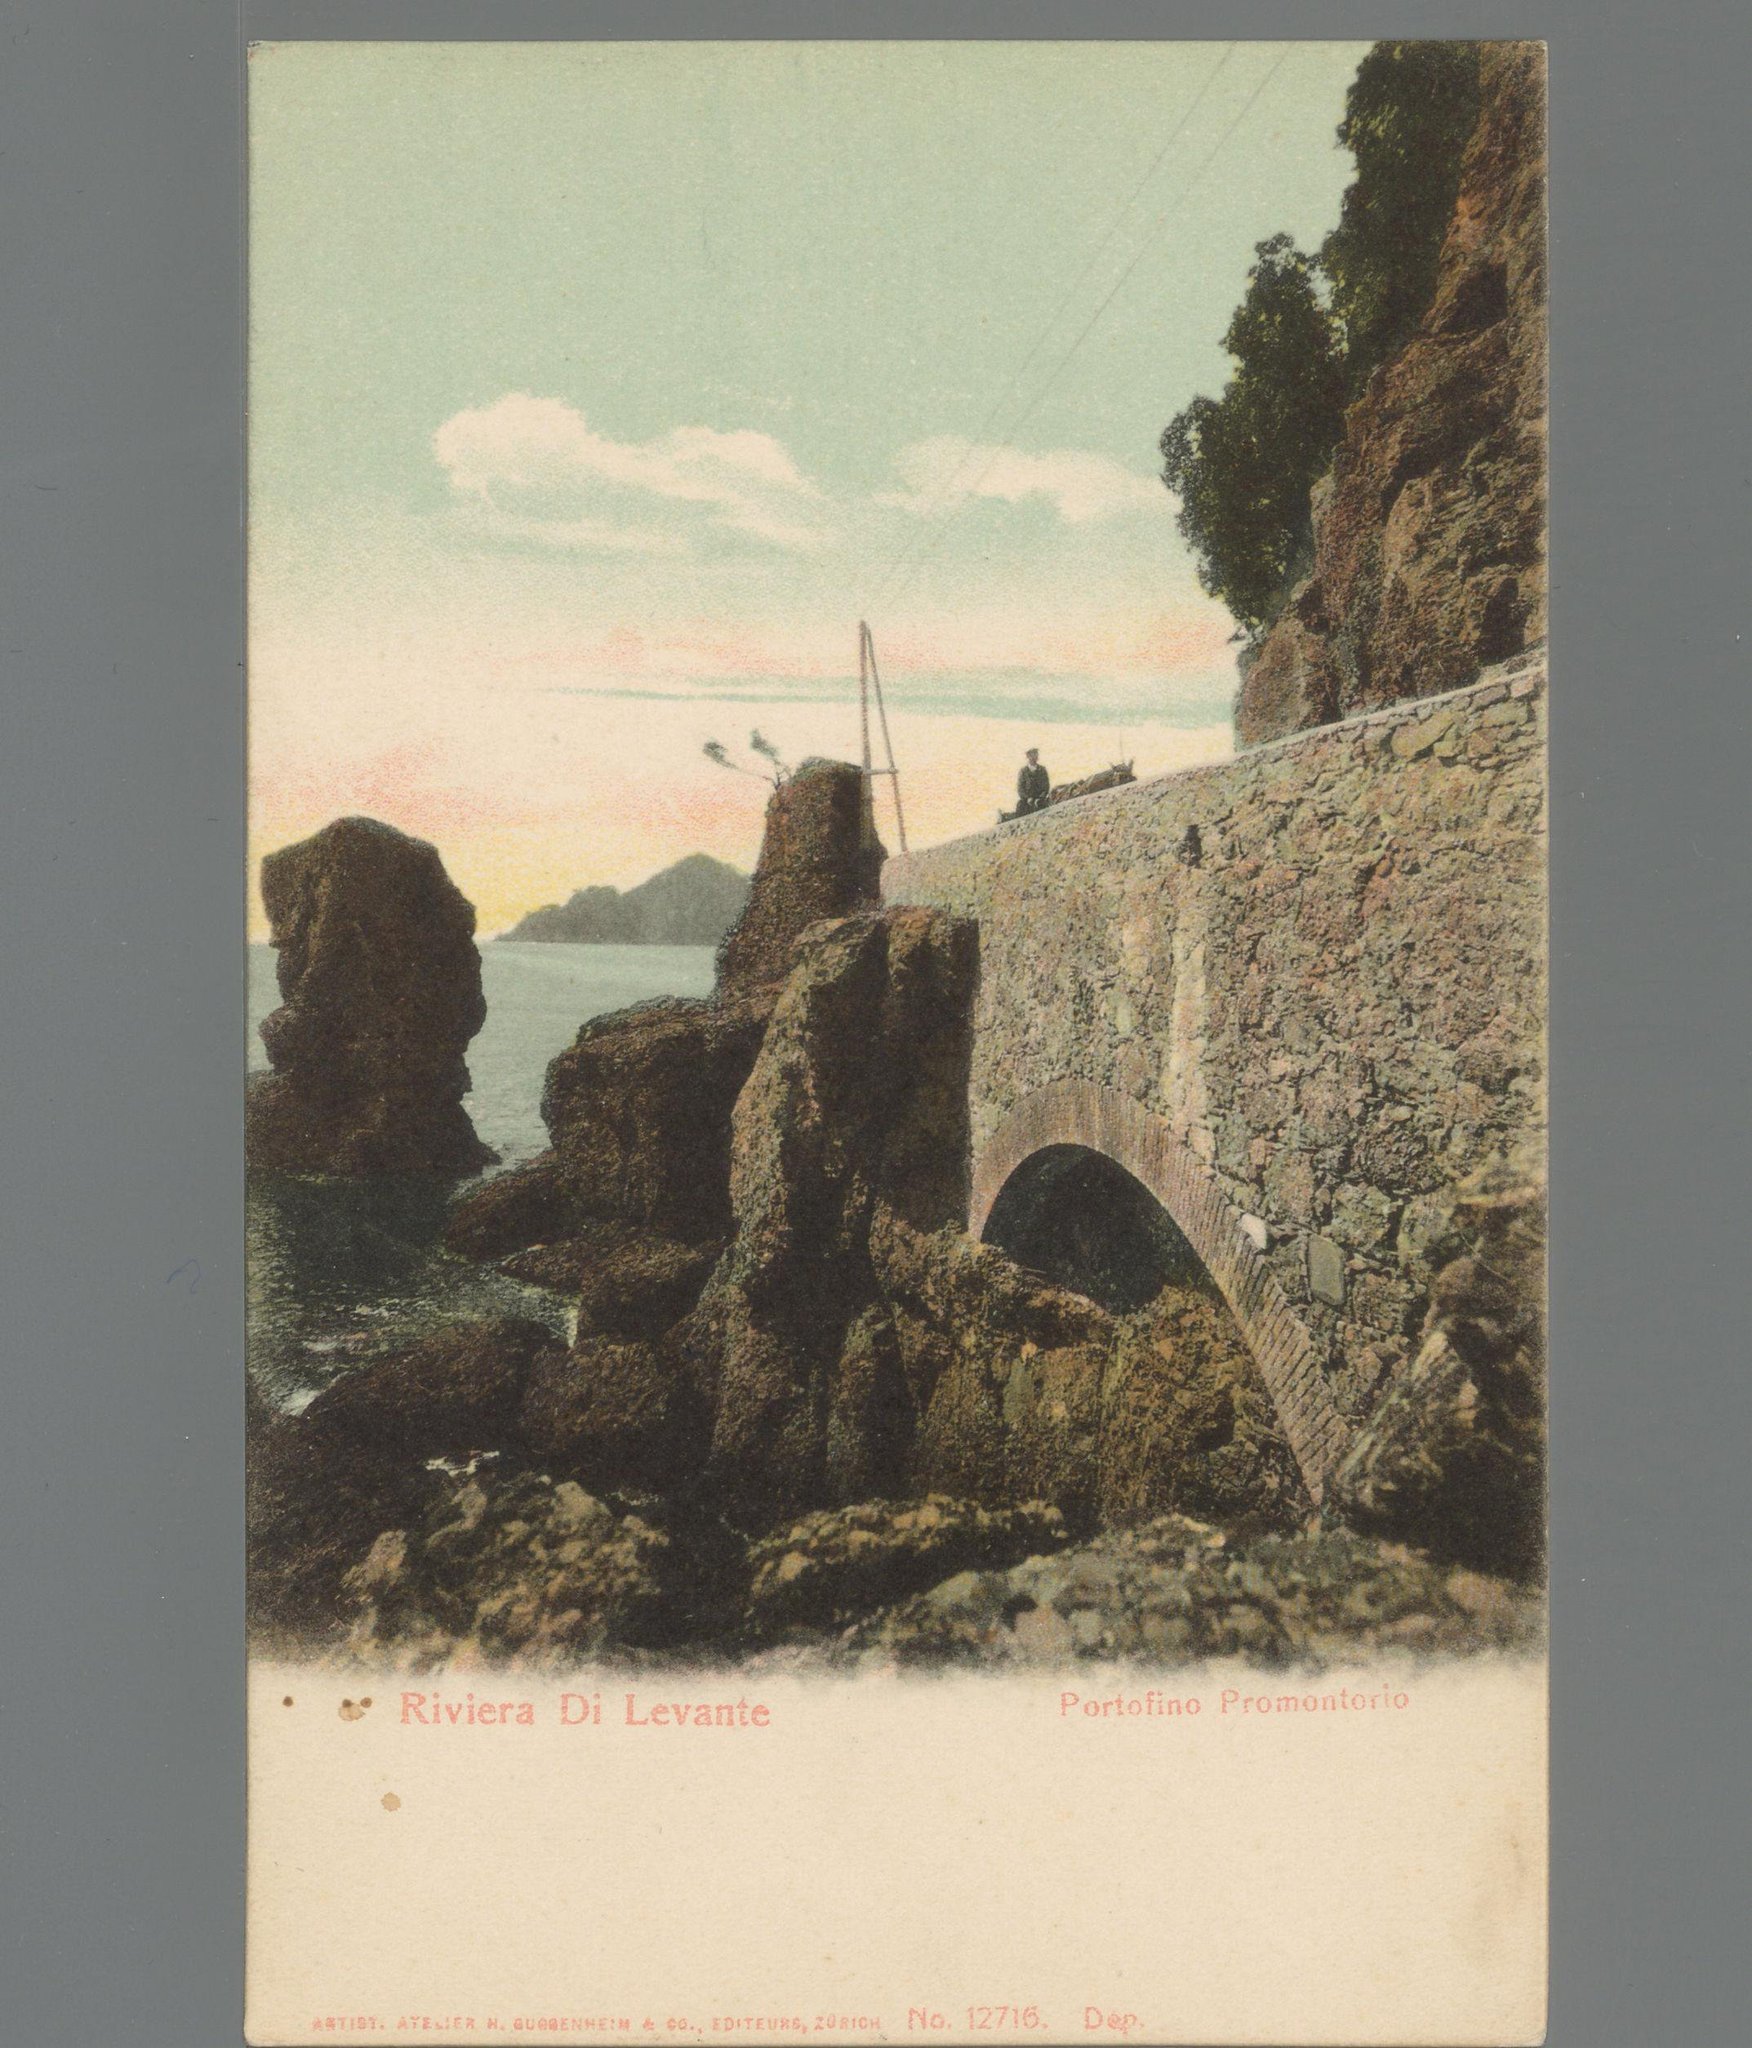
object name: ansichtkaart, prentbriefkaart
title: Riviera Di Levante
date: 1893-1905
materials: cardboard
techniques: photograph, lithograph, writing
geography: zurich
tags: rocky coast, bridge